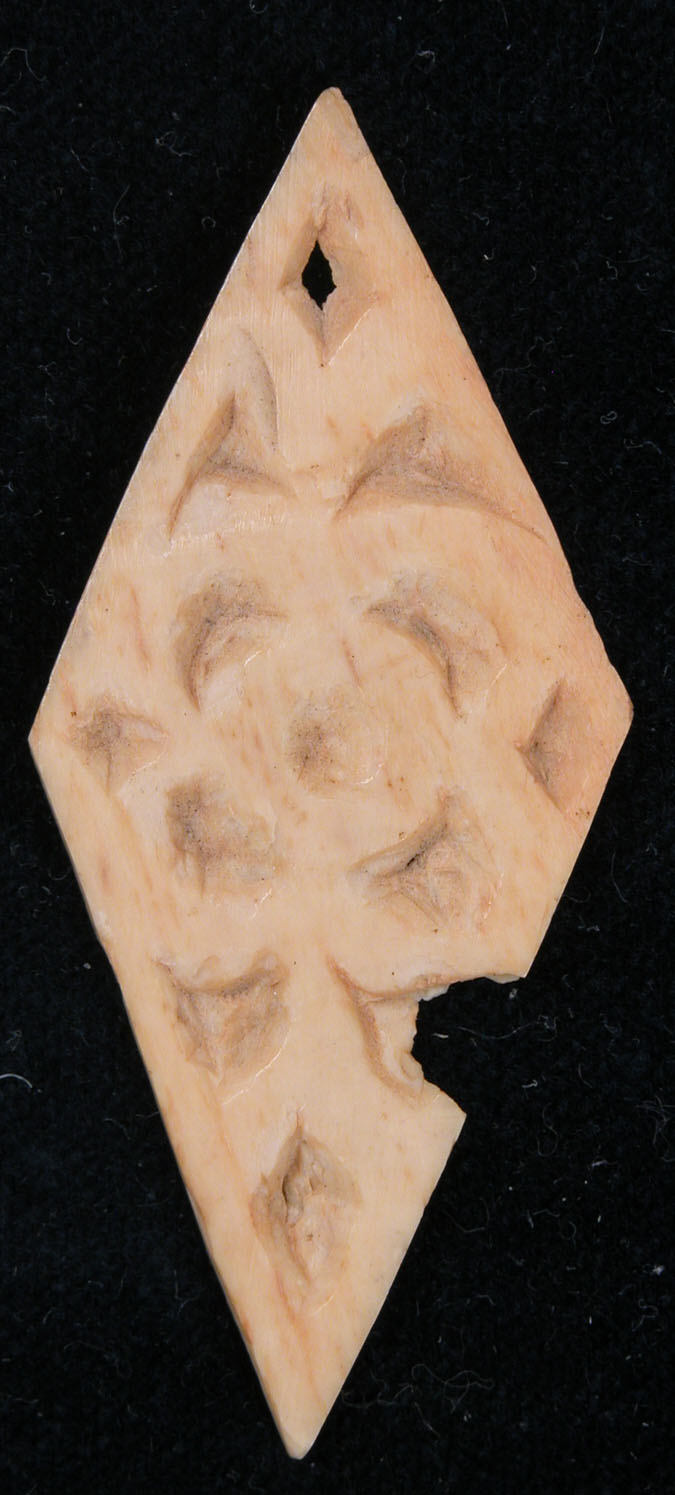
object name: plaque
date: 401-800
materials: bone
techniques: carving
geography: palestine